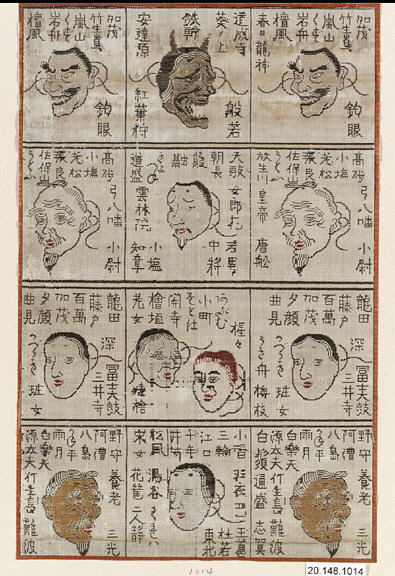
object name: piece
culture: japanese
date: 1701-1800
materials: silk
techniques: compound weave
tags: masks